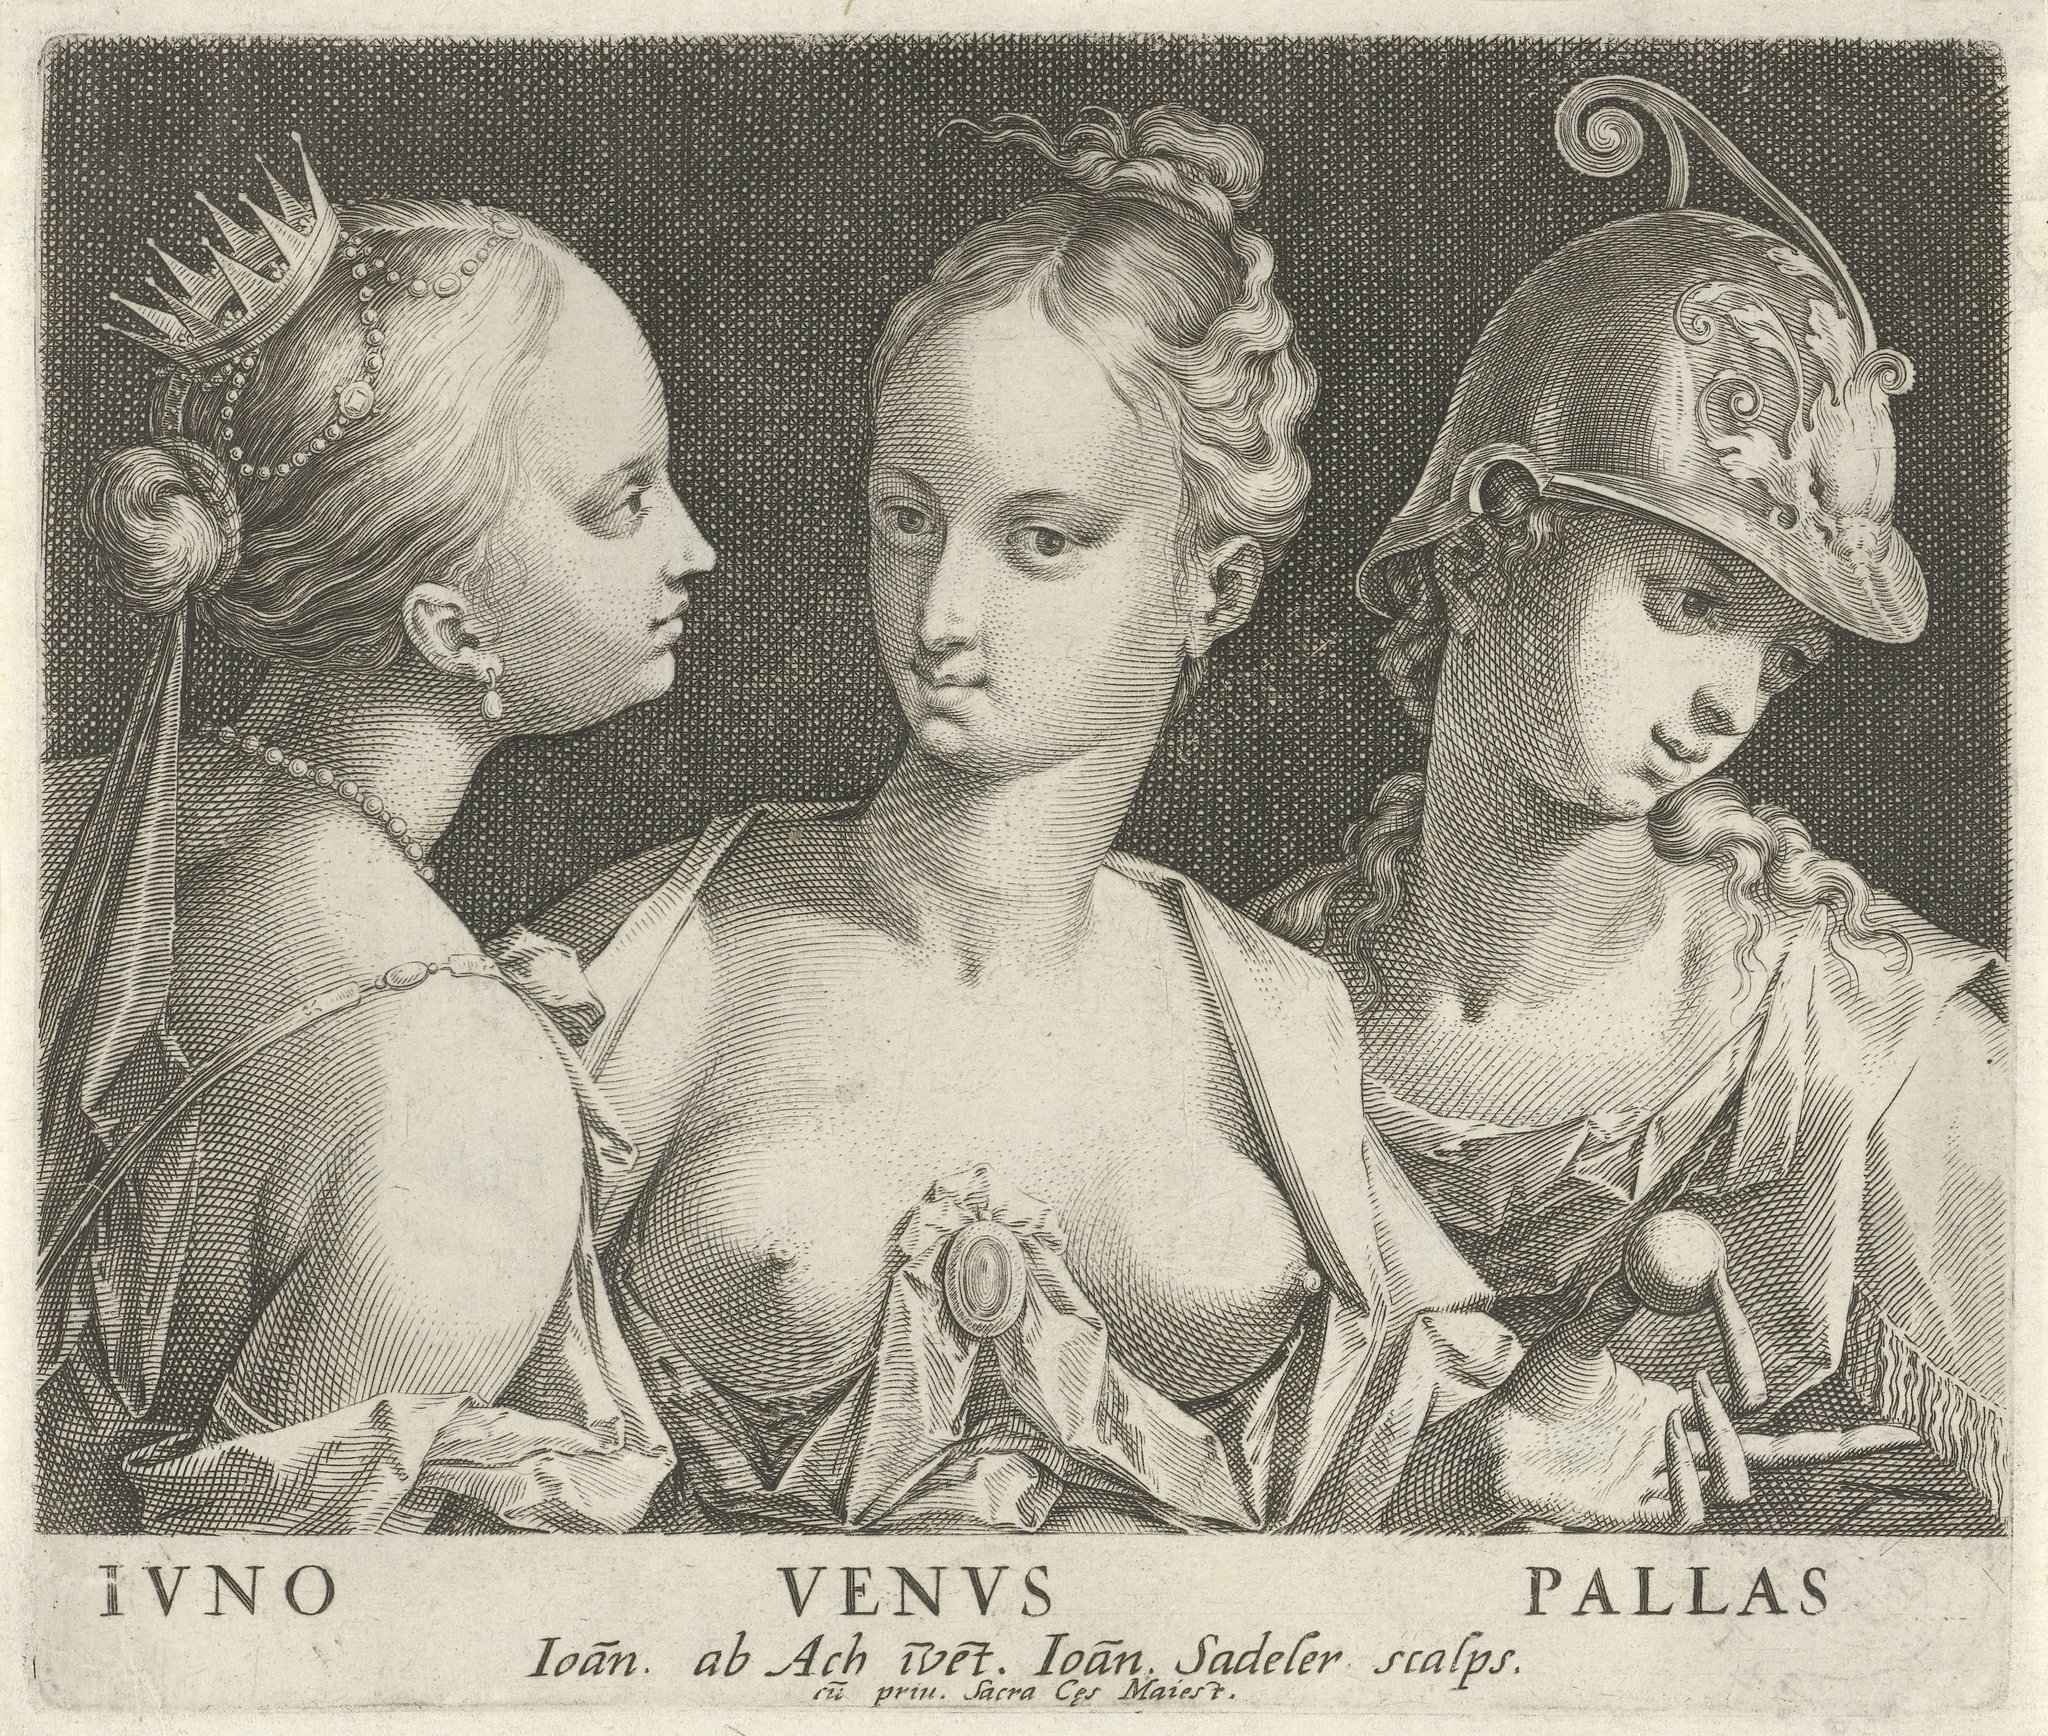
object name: print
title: Ivno Venvs Pallas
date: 1587-1595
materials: paper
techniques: engraving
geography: germany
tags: (story of) juno (hera), (story of) minerva (pallas, athena), (story of) venus (aphrodite)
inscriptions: collector's mark: Lugt 240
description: De bustes van de drie godinnen die de Trojaanse prins Paris beoordeelde op hun schoonheid. Juno (links met een kroon), Venus (in het midden met ontblote borsten en een appel in de hand) en Minerva (rechts met een helm).